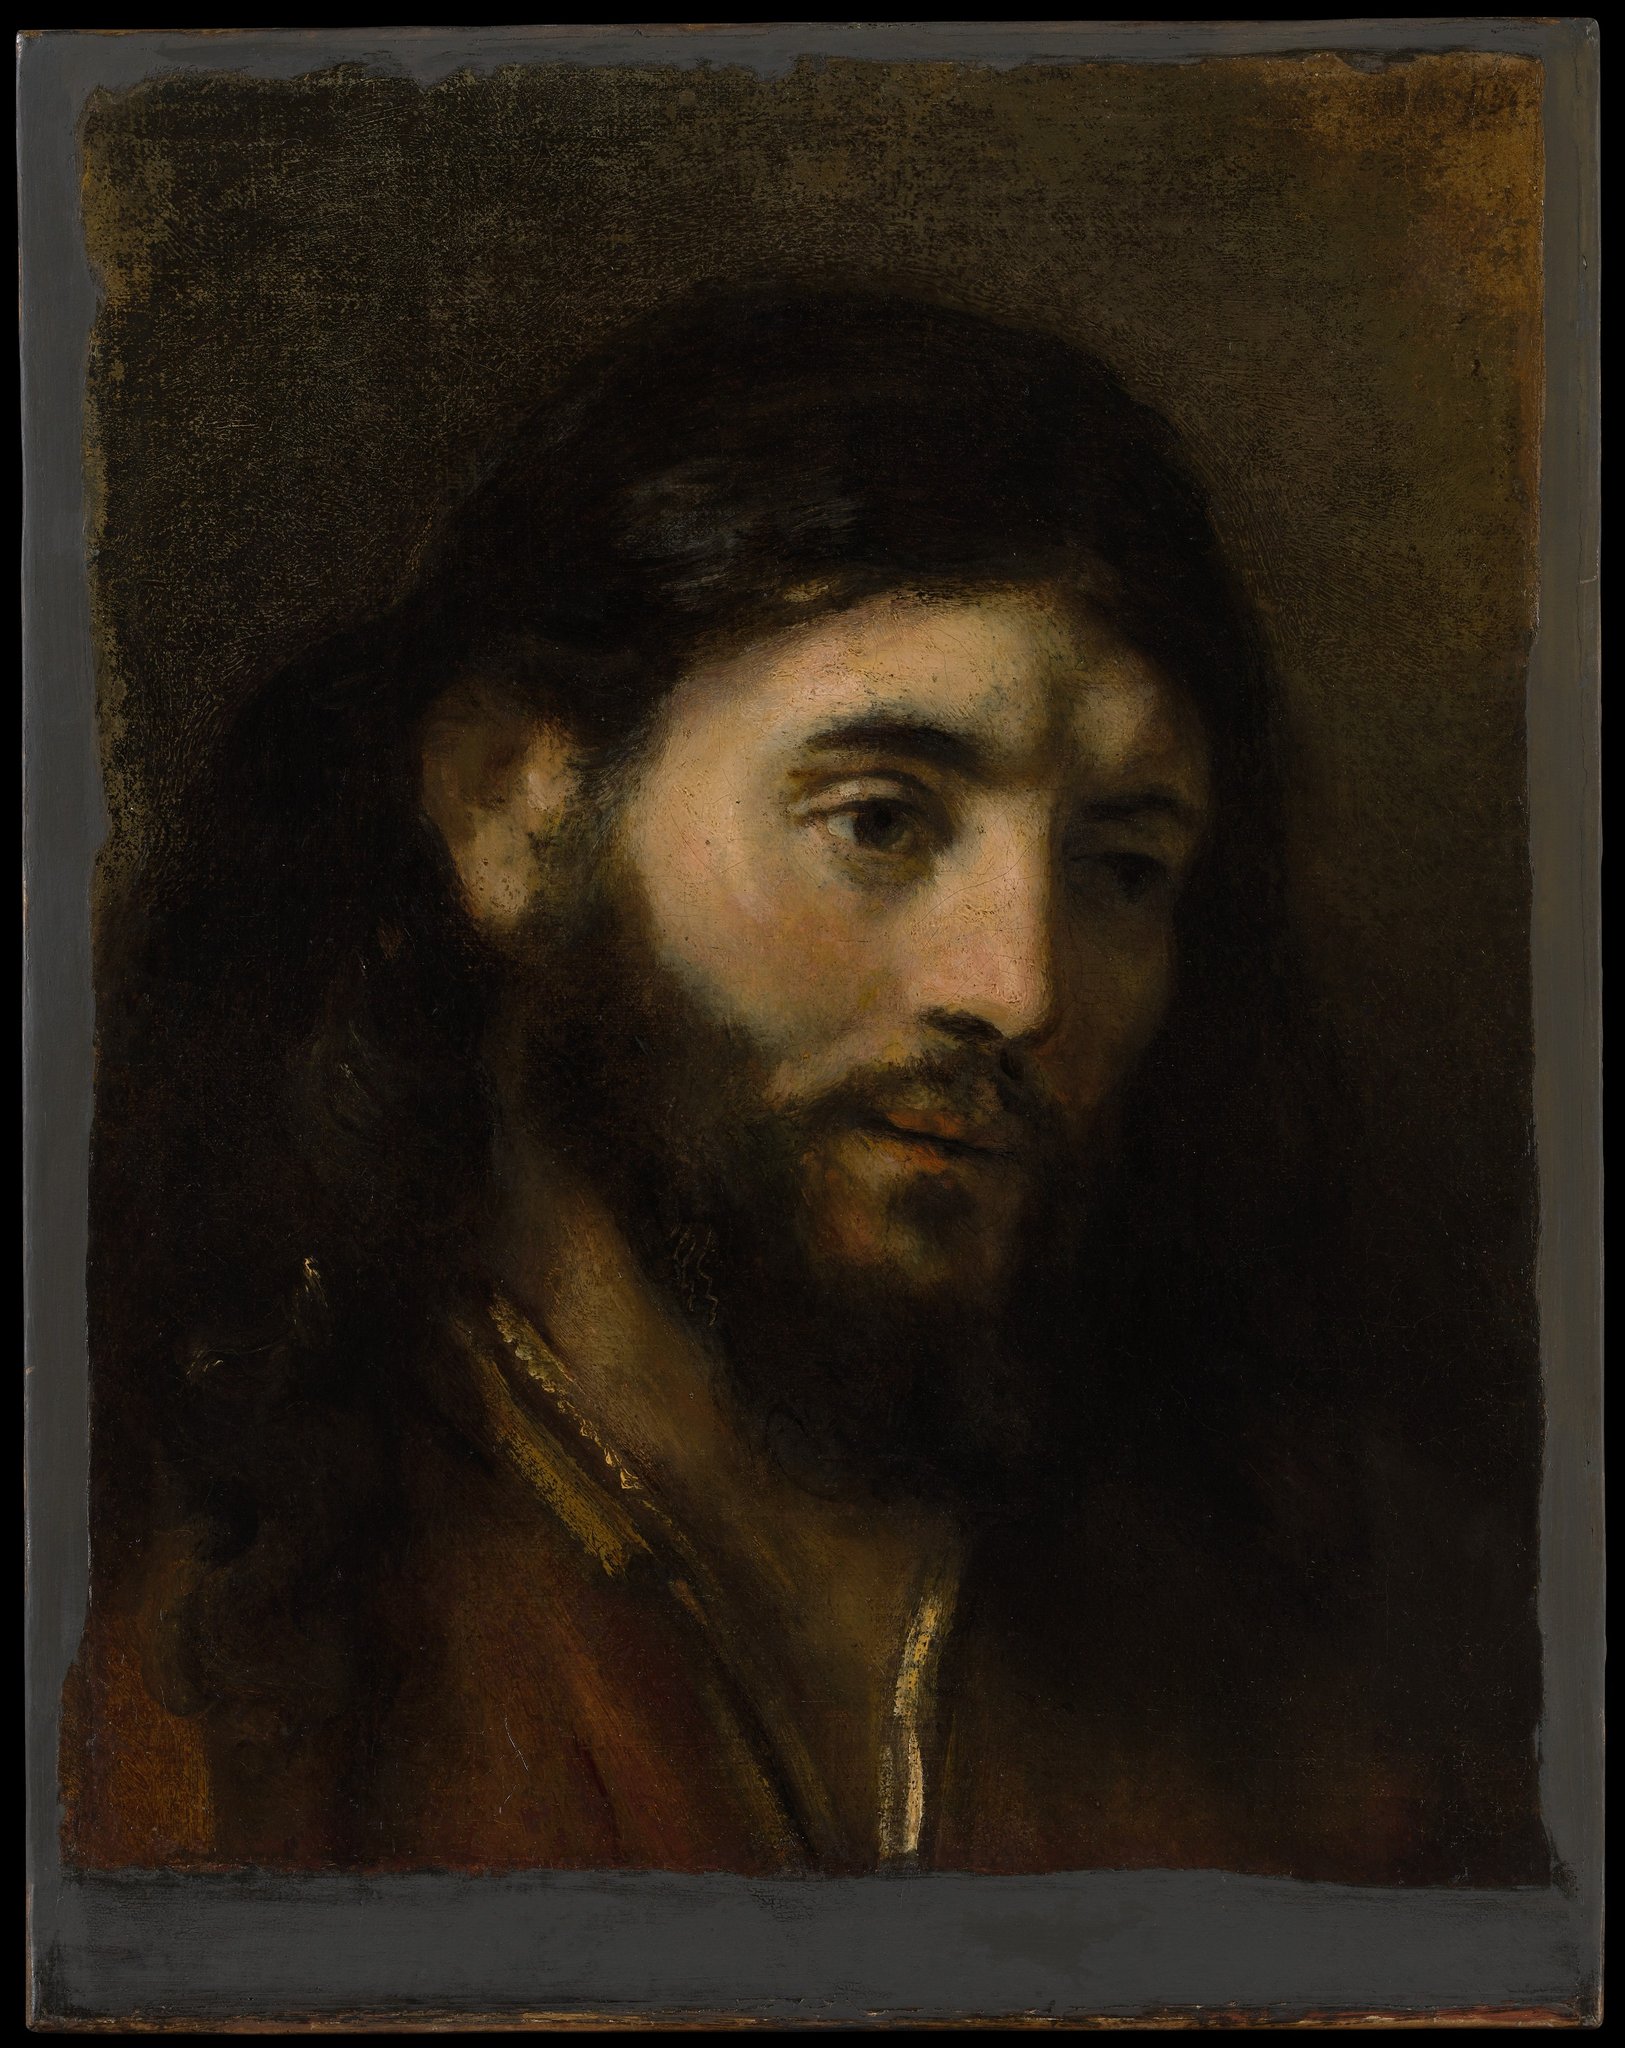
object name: painting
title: Head of Christ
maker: rembrandt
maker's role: artist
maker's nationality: dutch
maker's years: 1606-1669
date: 1626-1669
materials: canvas, oil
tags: christ